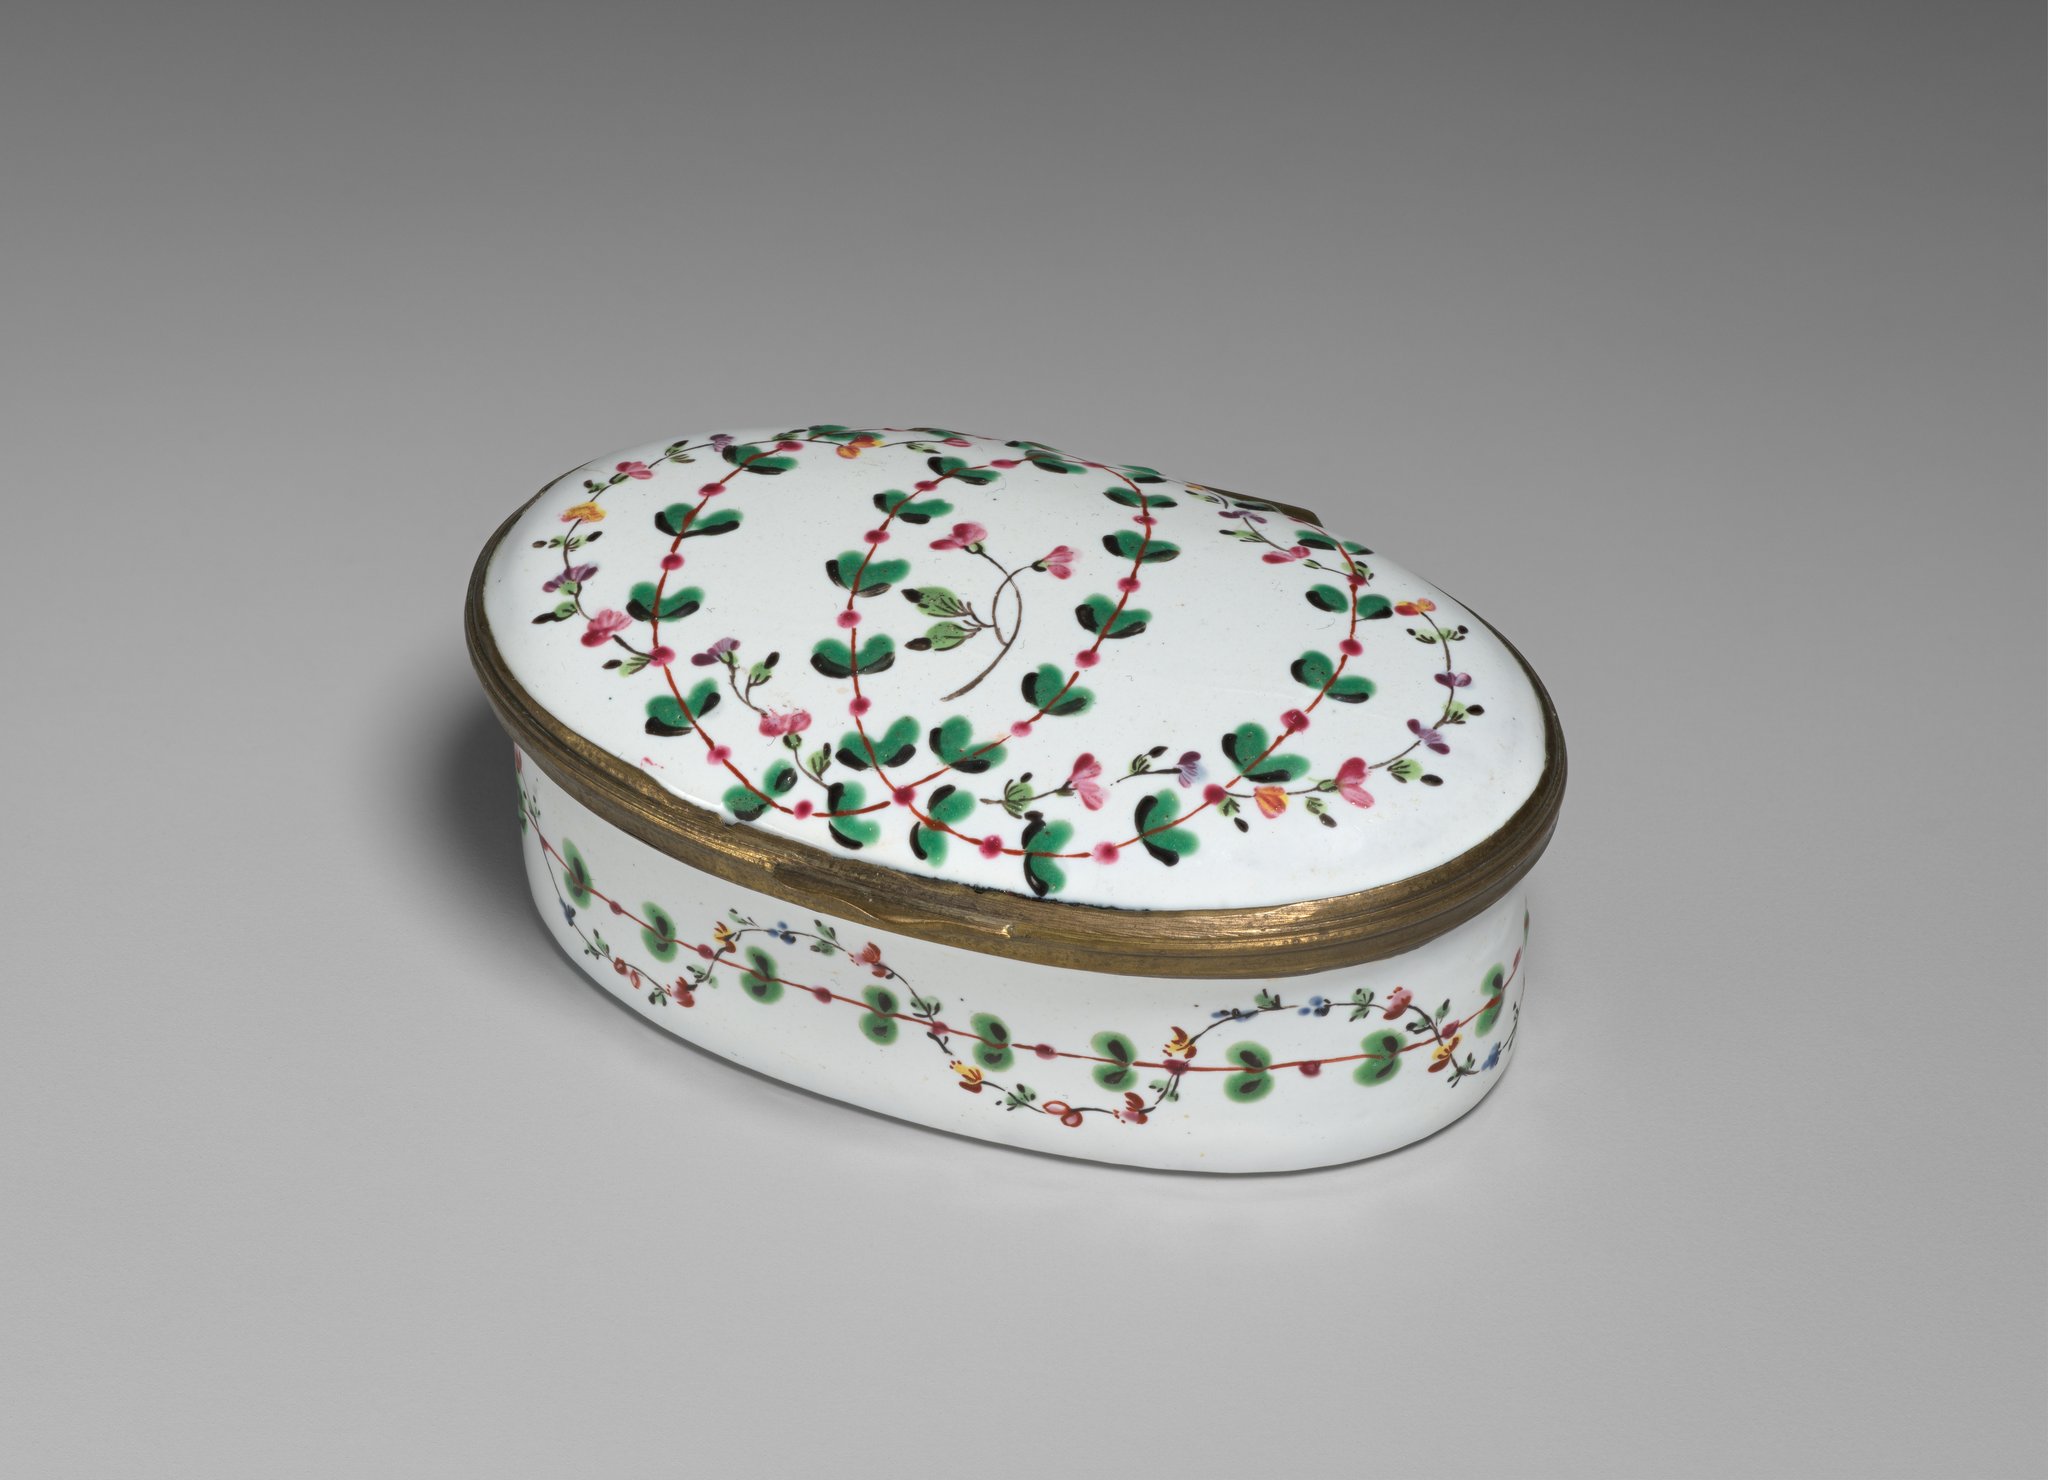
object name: snuffbox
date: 1770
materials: copper, enamel